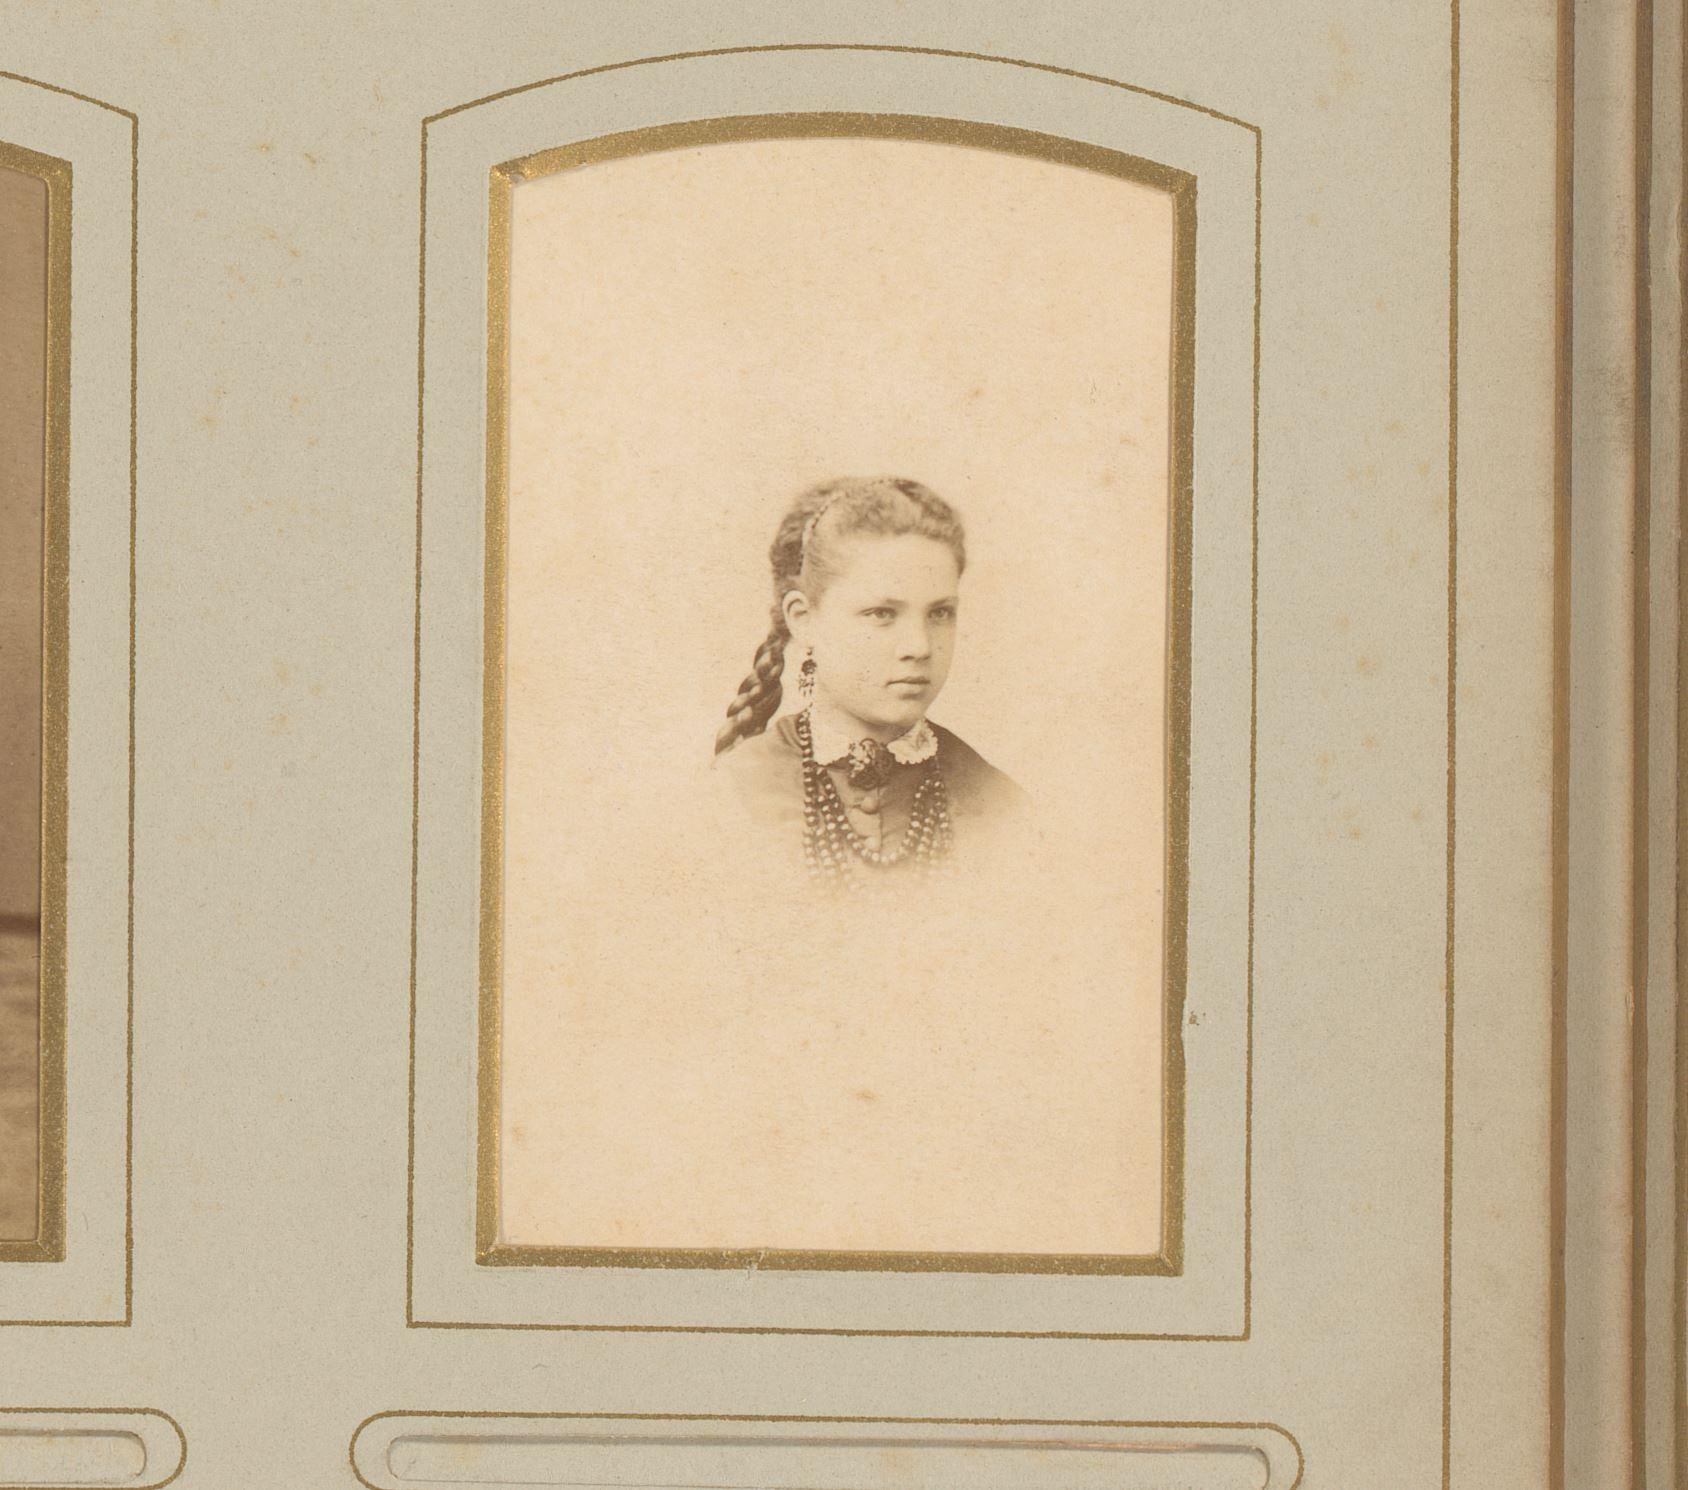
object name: photograph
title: Portret van een meisje met halskettingen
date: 1866-1900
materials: cardboard, photographic support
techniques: albumen print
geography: brussels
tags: historical persons - bb - woman, necklace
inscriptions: inscription: ‘GÉRUZET FRÈRES/ PHOTOGRAPHES/ de S.M. la Reine des Belges./ 27bis Rue de L'Ecuyer./ BRUXELLES./ Les Clichés se conservant indéfiniment/ on peut toujours se procurer de nouvelles/ épreuves de ce Portrait sans reposer.’, name: ‘Ghesquiere’